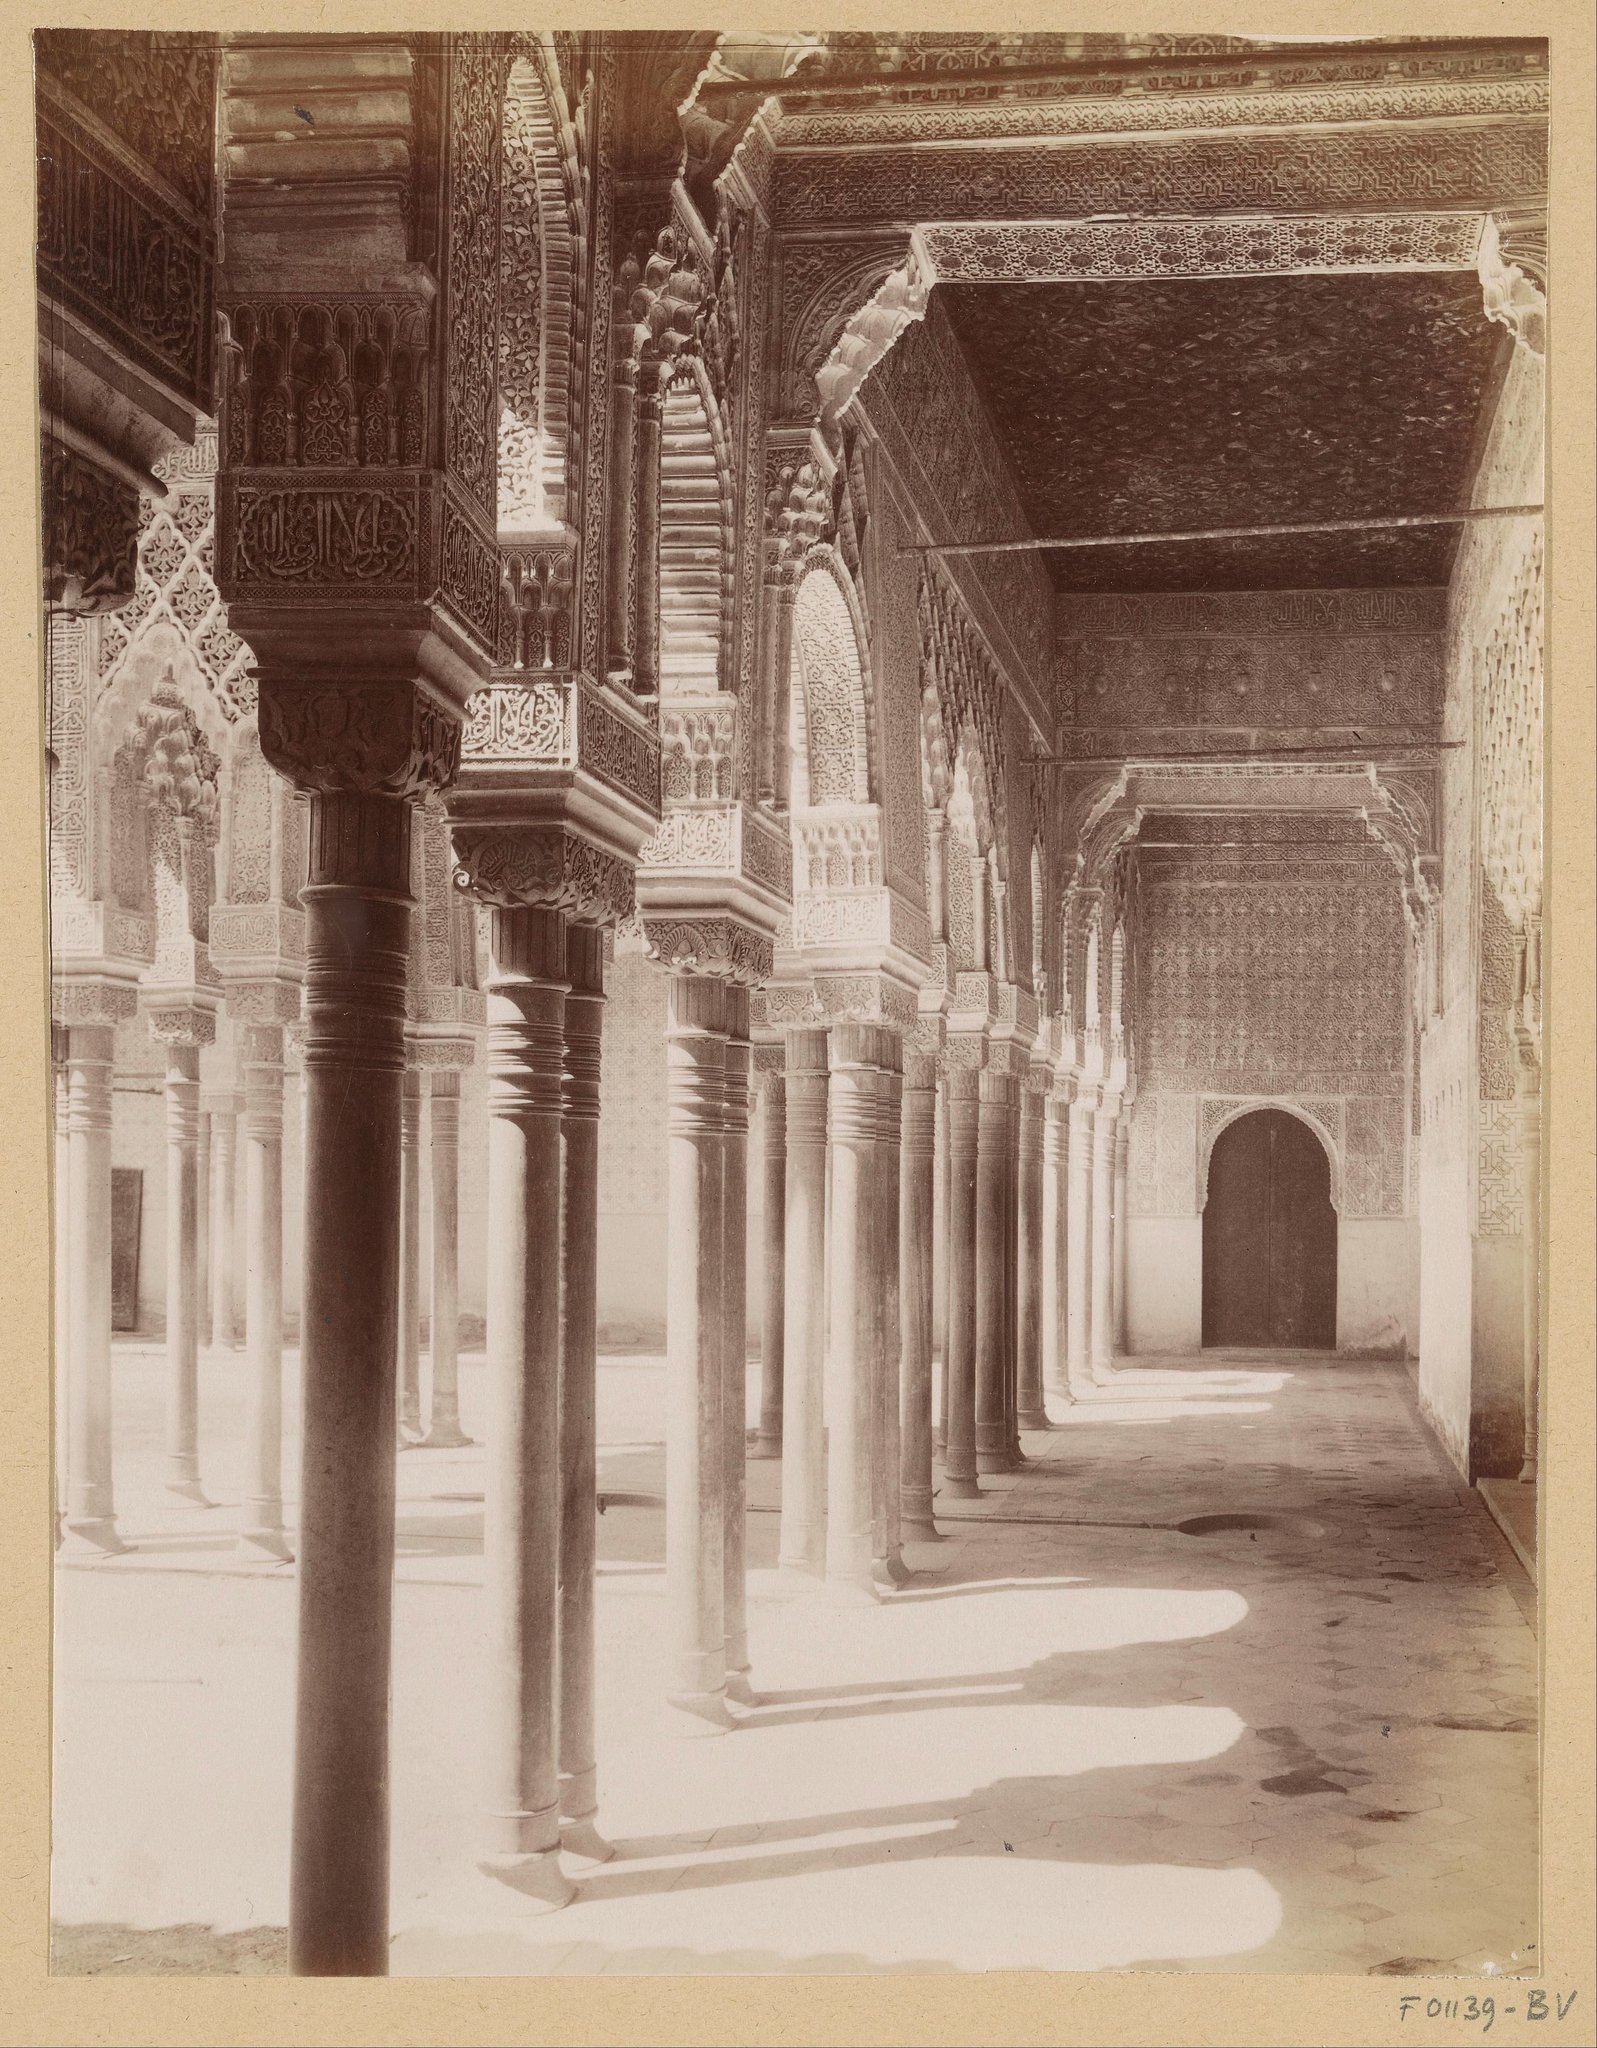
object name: photograph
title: Patio de los Leones in het Alhambra in Granada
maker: Anonymous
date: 1851-1890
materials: paper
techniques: albumen print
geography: granada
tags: courtyard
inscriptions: inscription: ‘Patio de los Leones/ Alhambra/ Granada’